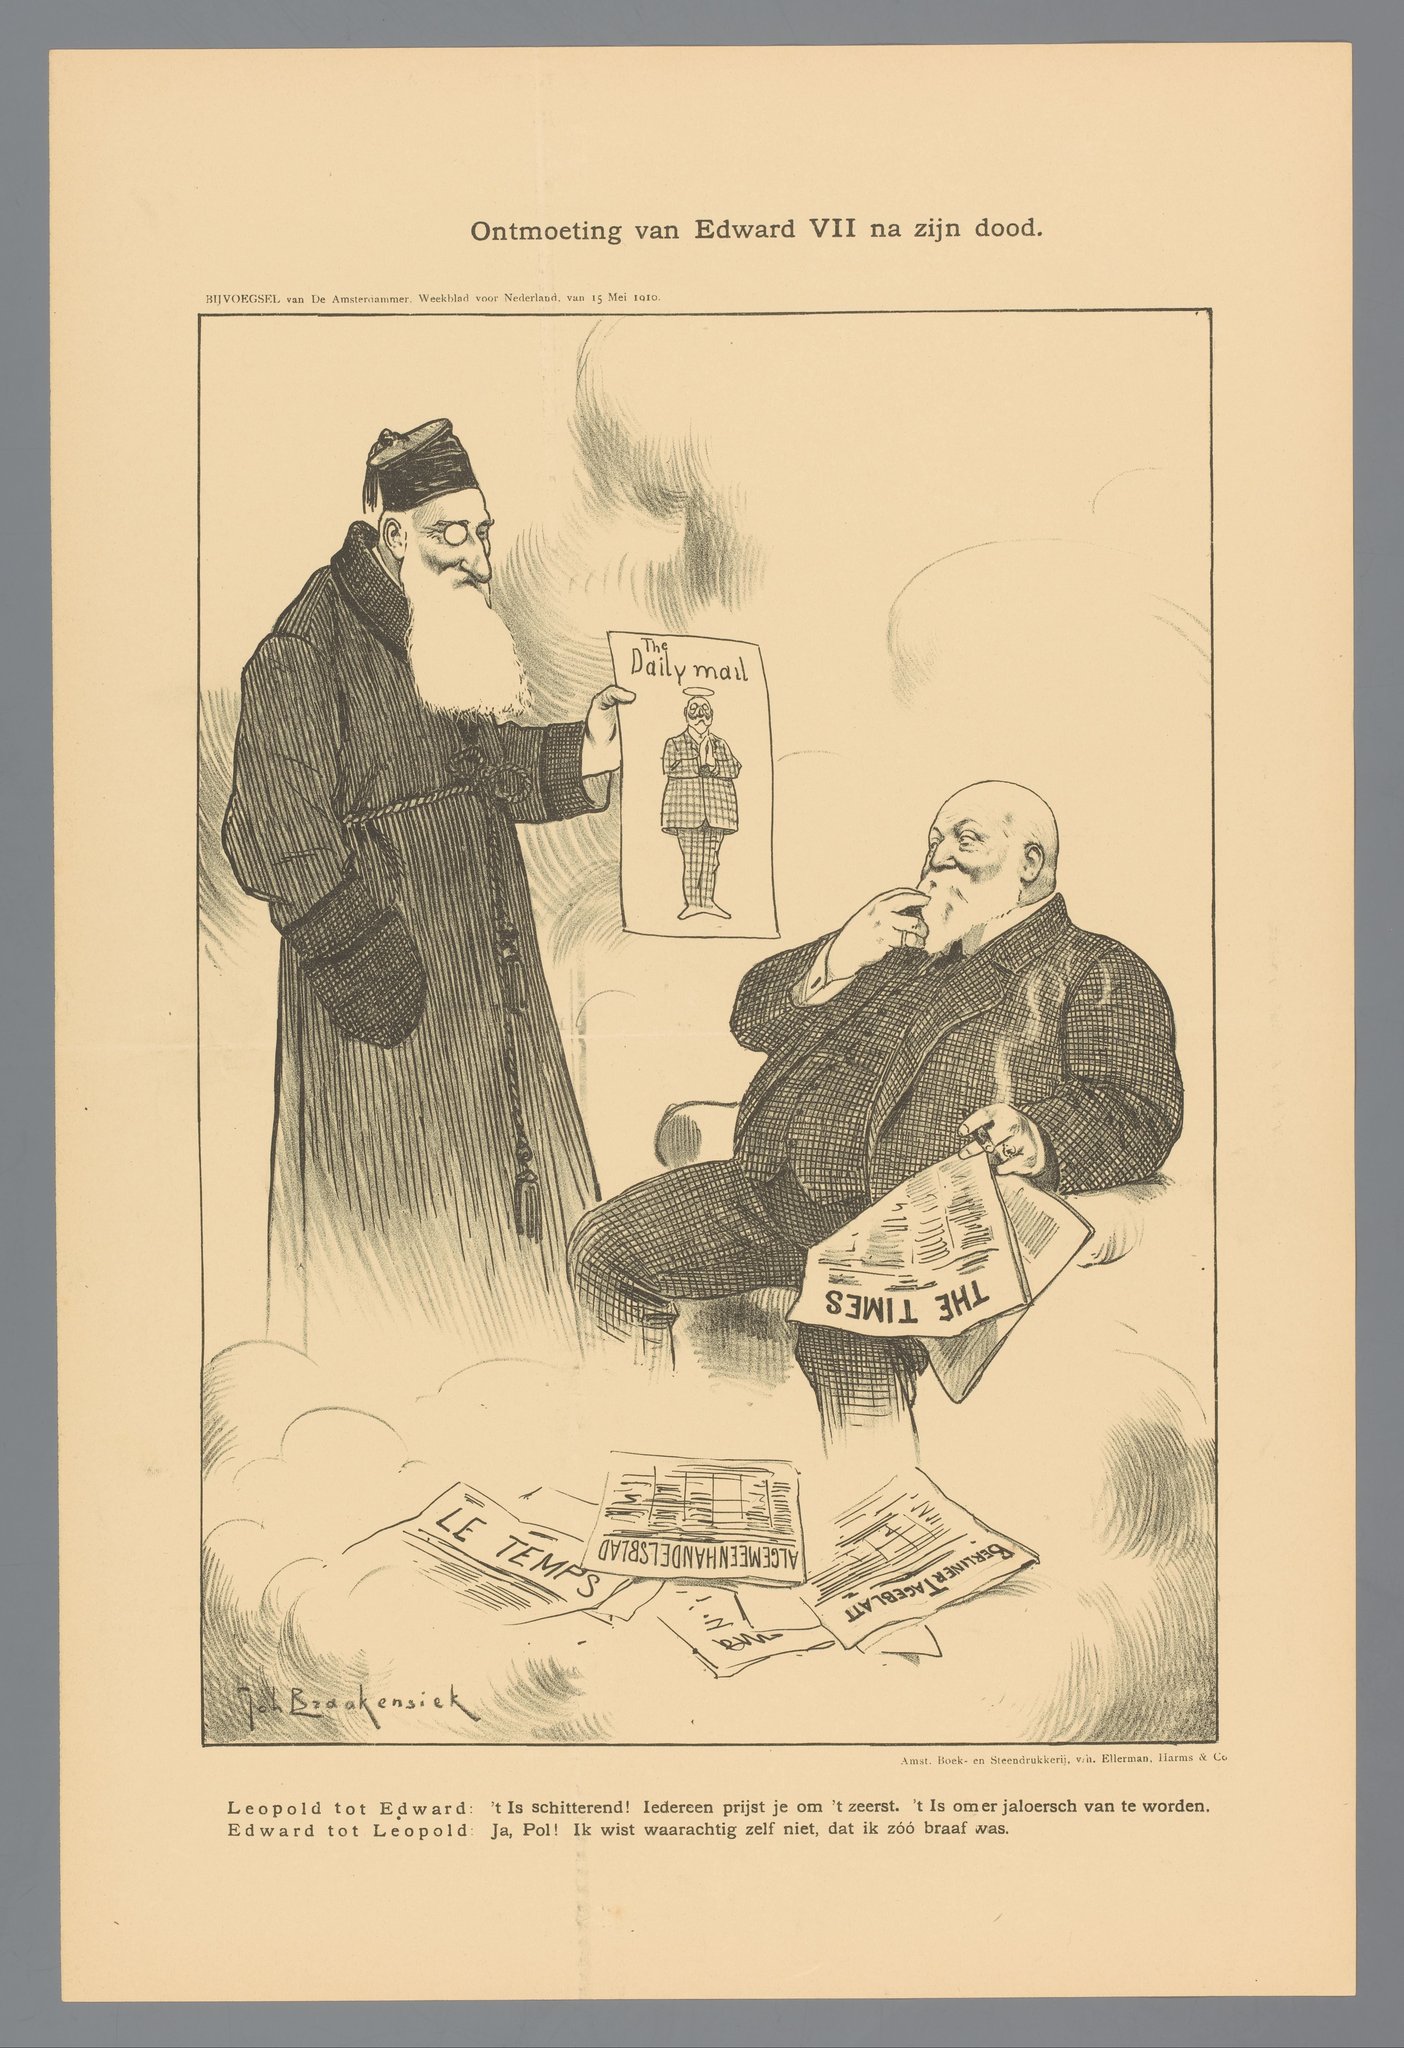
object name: cartoon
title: Ontmoeting van Edward VII na zijn dood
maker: johan braakensiek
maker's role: draughtsman, print maker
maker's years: 1858-1940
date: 1910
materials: paper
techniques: lithograph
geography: amsterdam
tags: brussels, laeken, leopold ii (koning der belgen), historical persons, political caricatures and satires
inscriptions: date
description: Prent uit het bijvoegsel van: De Amsterdammer. Weekblad voor Nederland, 15 mei 1910.